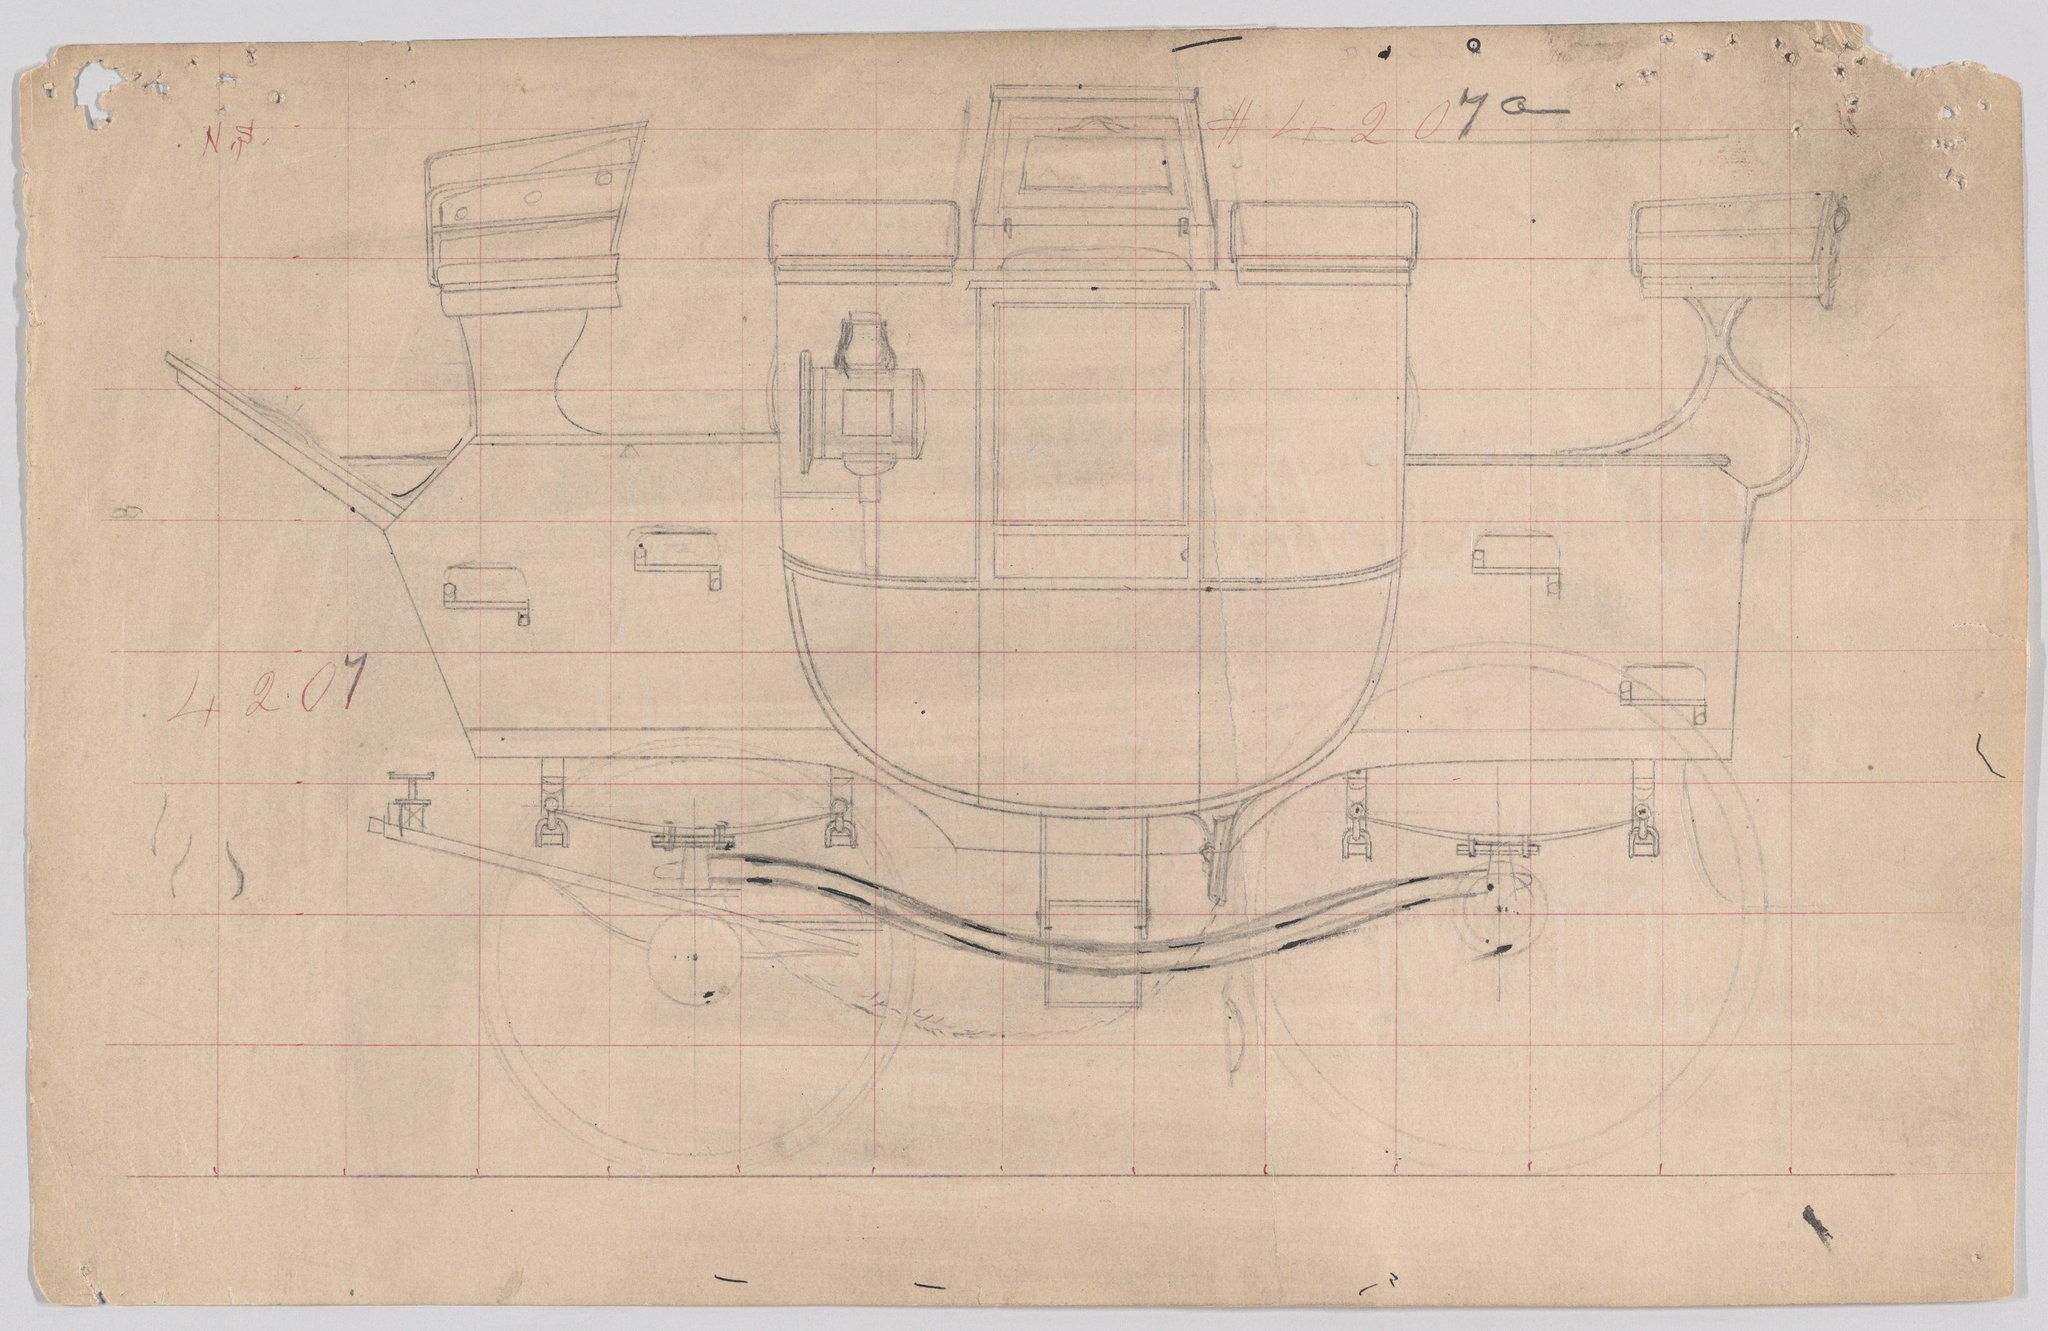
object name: drawing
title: Park Drag #4207a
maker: brewster & co.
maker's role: manufacturer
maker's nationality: american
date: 1893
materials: graphite, ink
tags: carriages